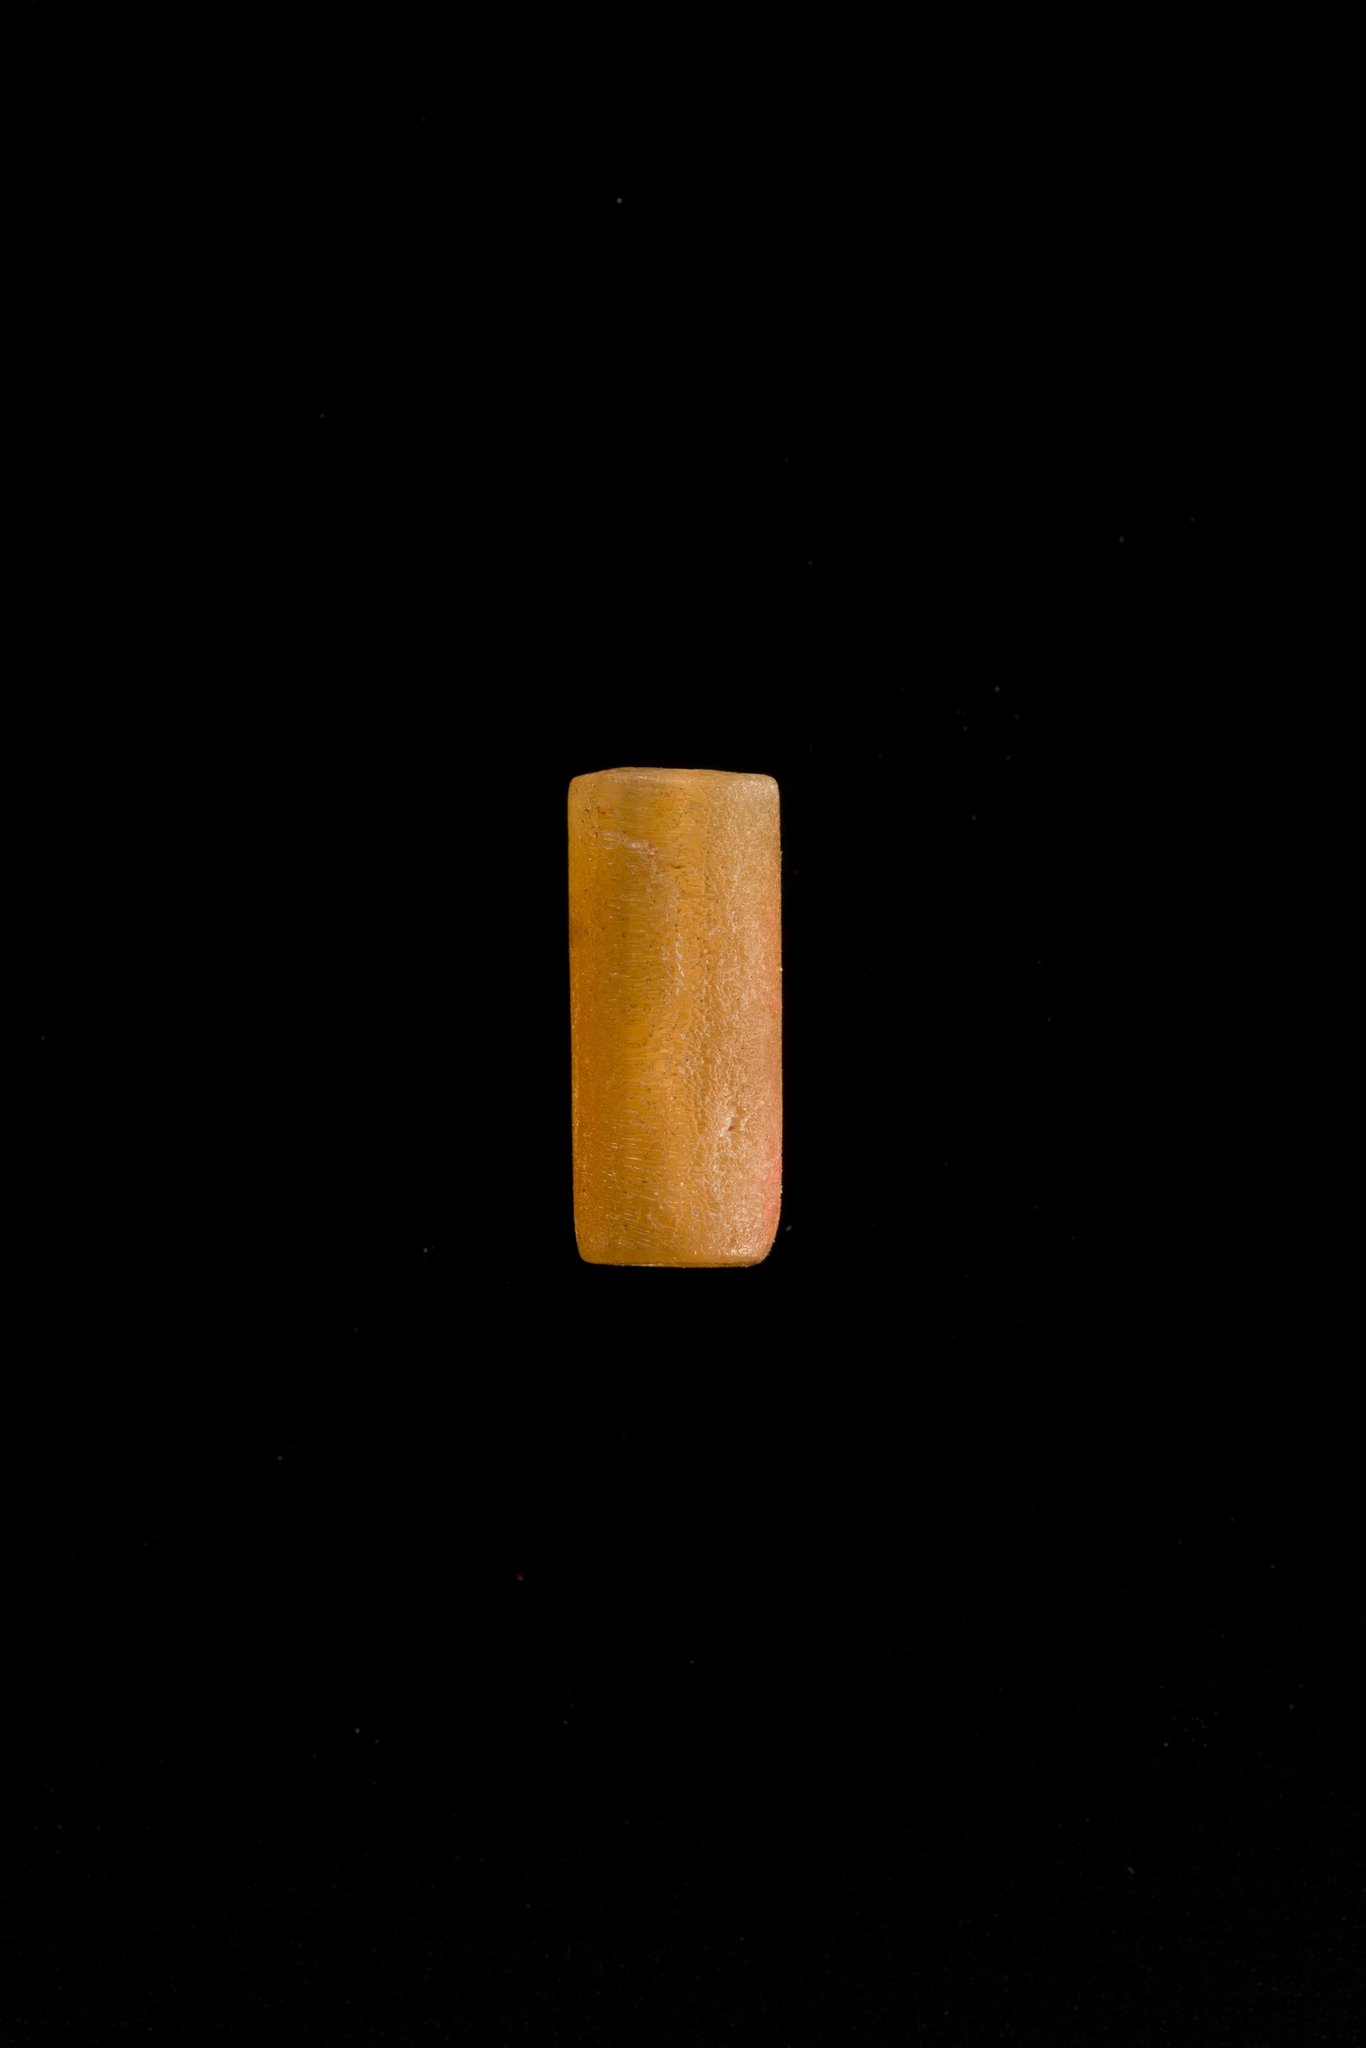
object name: bead, cylinder, nesenaset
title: Cylinder bead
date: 1070-945 BCE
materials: gemstone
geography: egypt